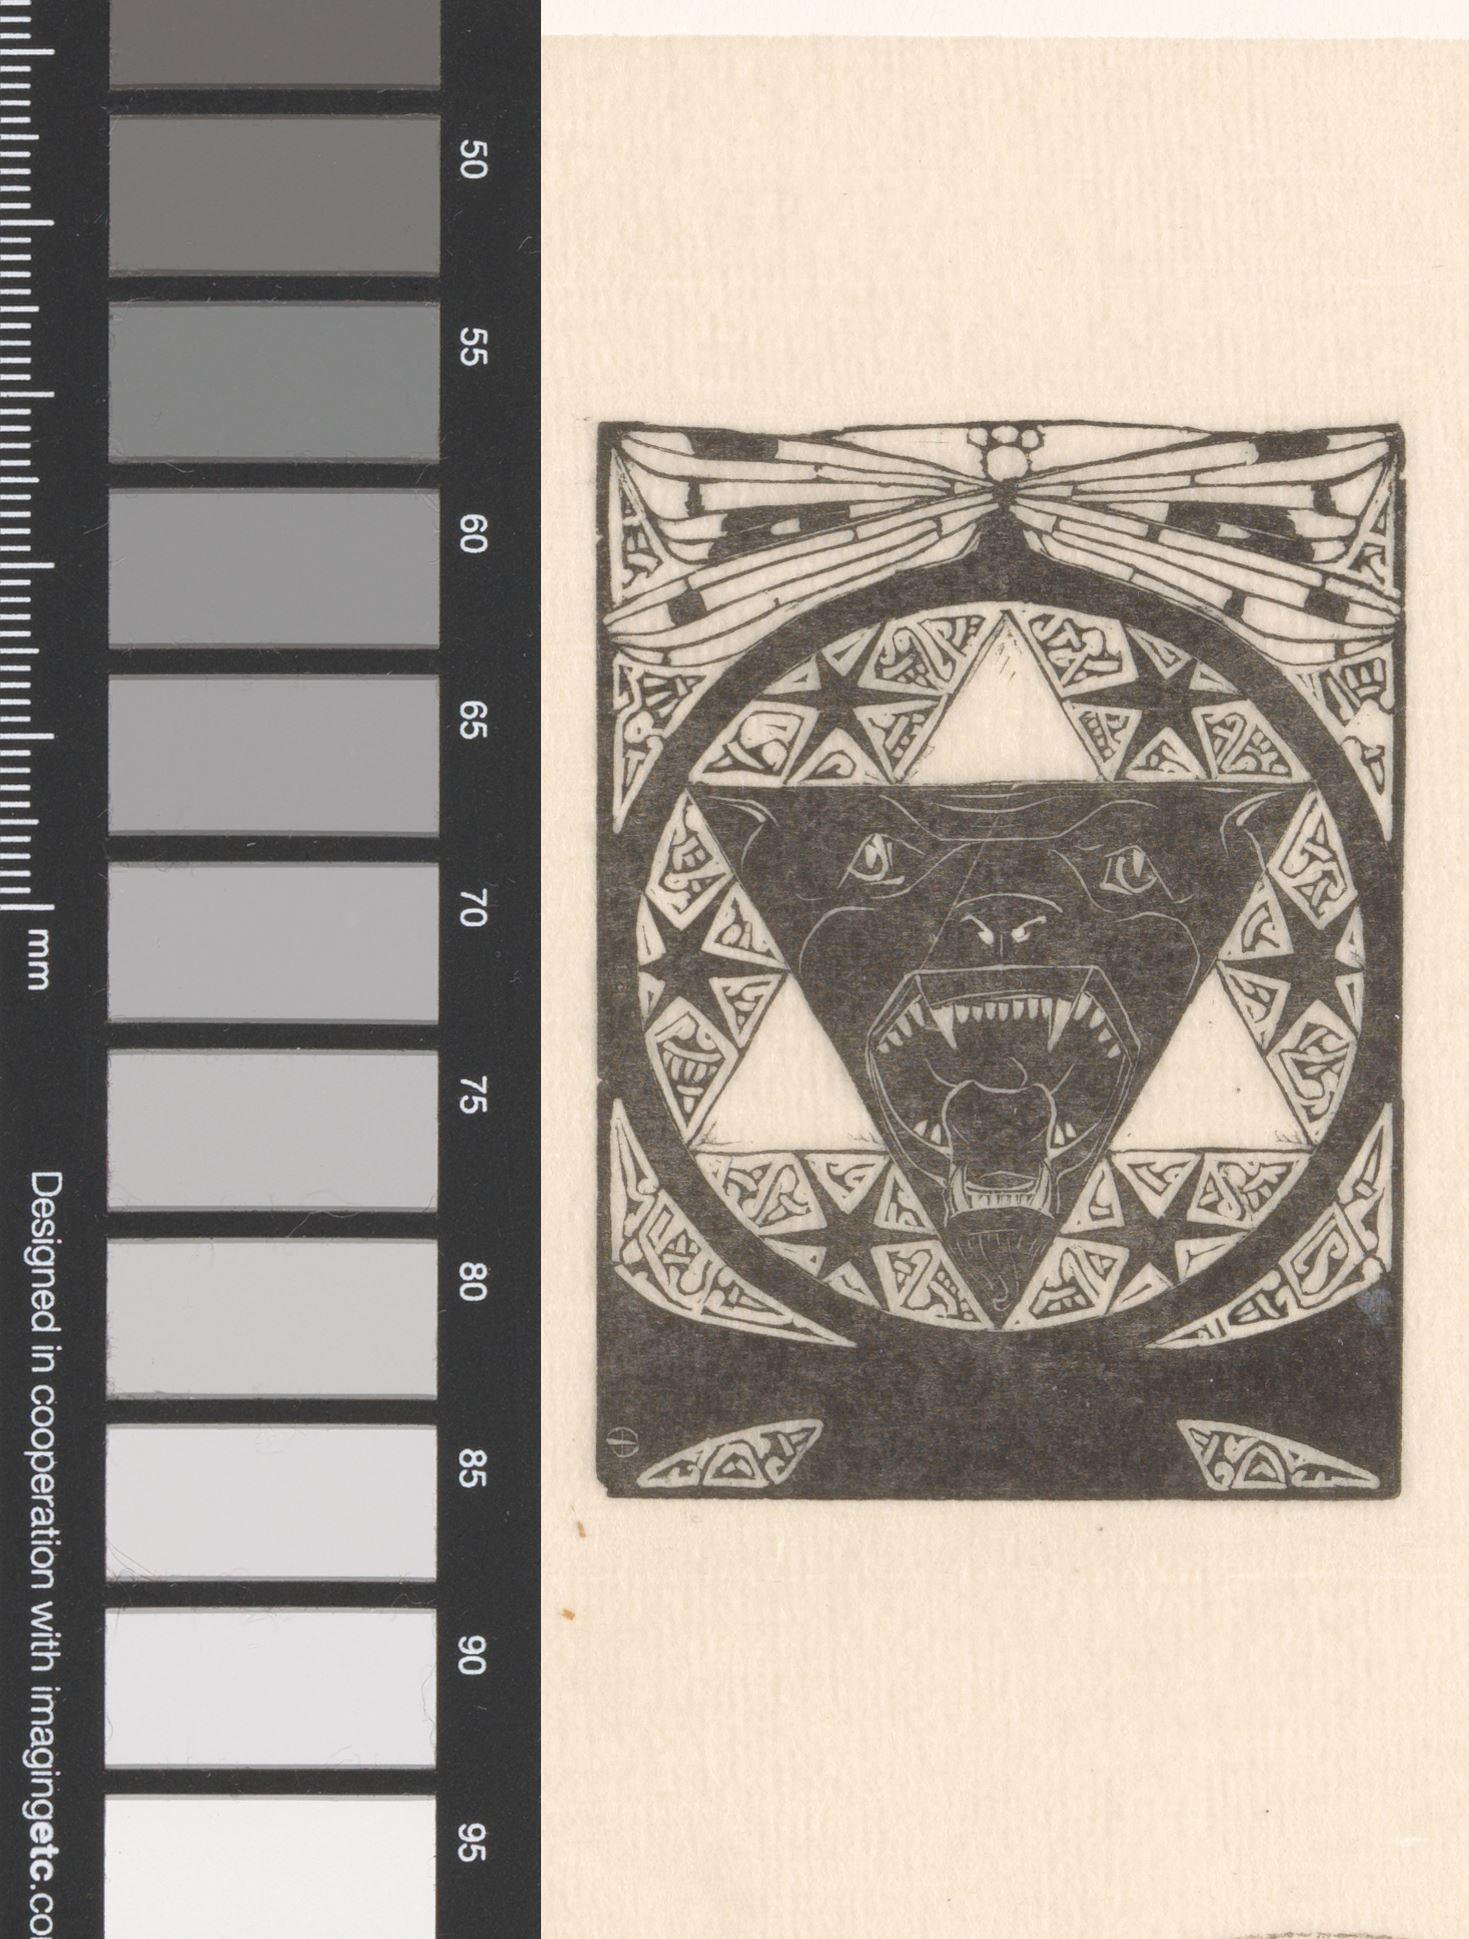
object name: print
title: Theosofisch embleem met brullende hondenkop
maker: mathieu lauweriks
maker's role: designer, draughtsman, print maker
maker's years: 1864-1932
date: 1895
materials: paper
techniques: woodcut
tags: stars, dog (+ head of an animal)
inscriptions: collector's mark: Lugt 2228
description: Een cirkel met bovenaan vleugels. In de cirkel zes sterren, een witte naar boven gerichte driehoek en een zwarte naar onder gerichte driehoek. In de zwarte driehoek een brullende hondenkop.